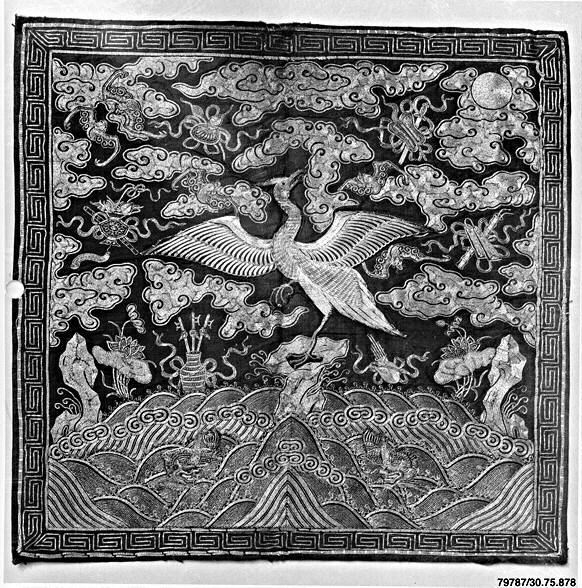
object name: rank badge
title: Rank Badge with Egret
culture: chinese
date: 1801-1900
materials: metal thread, silk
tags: birds